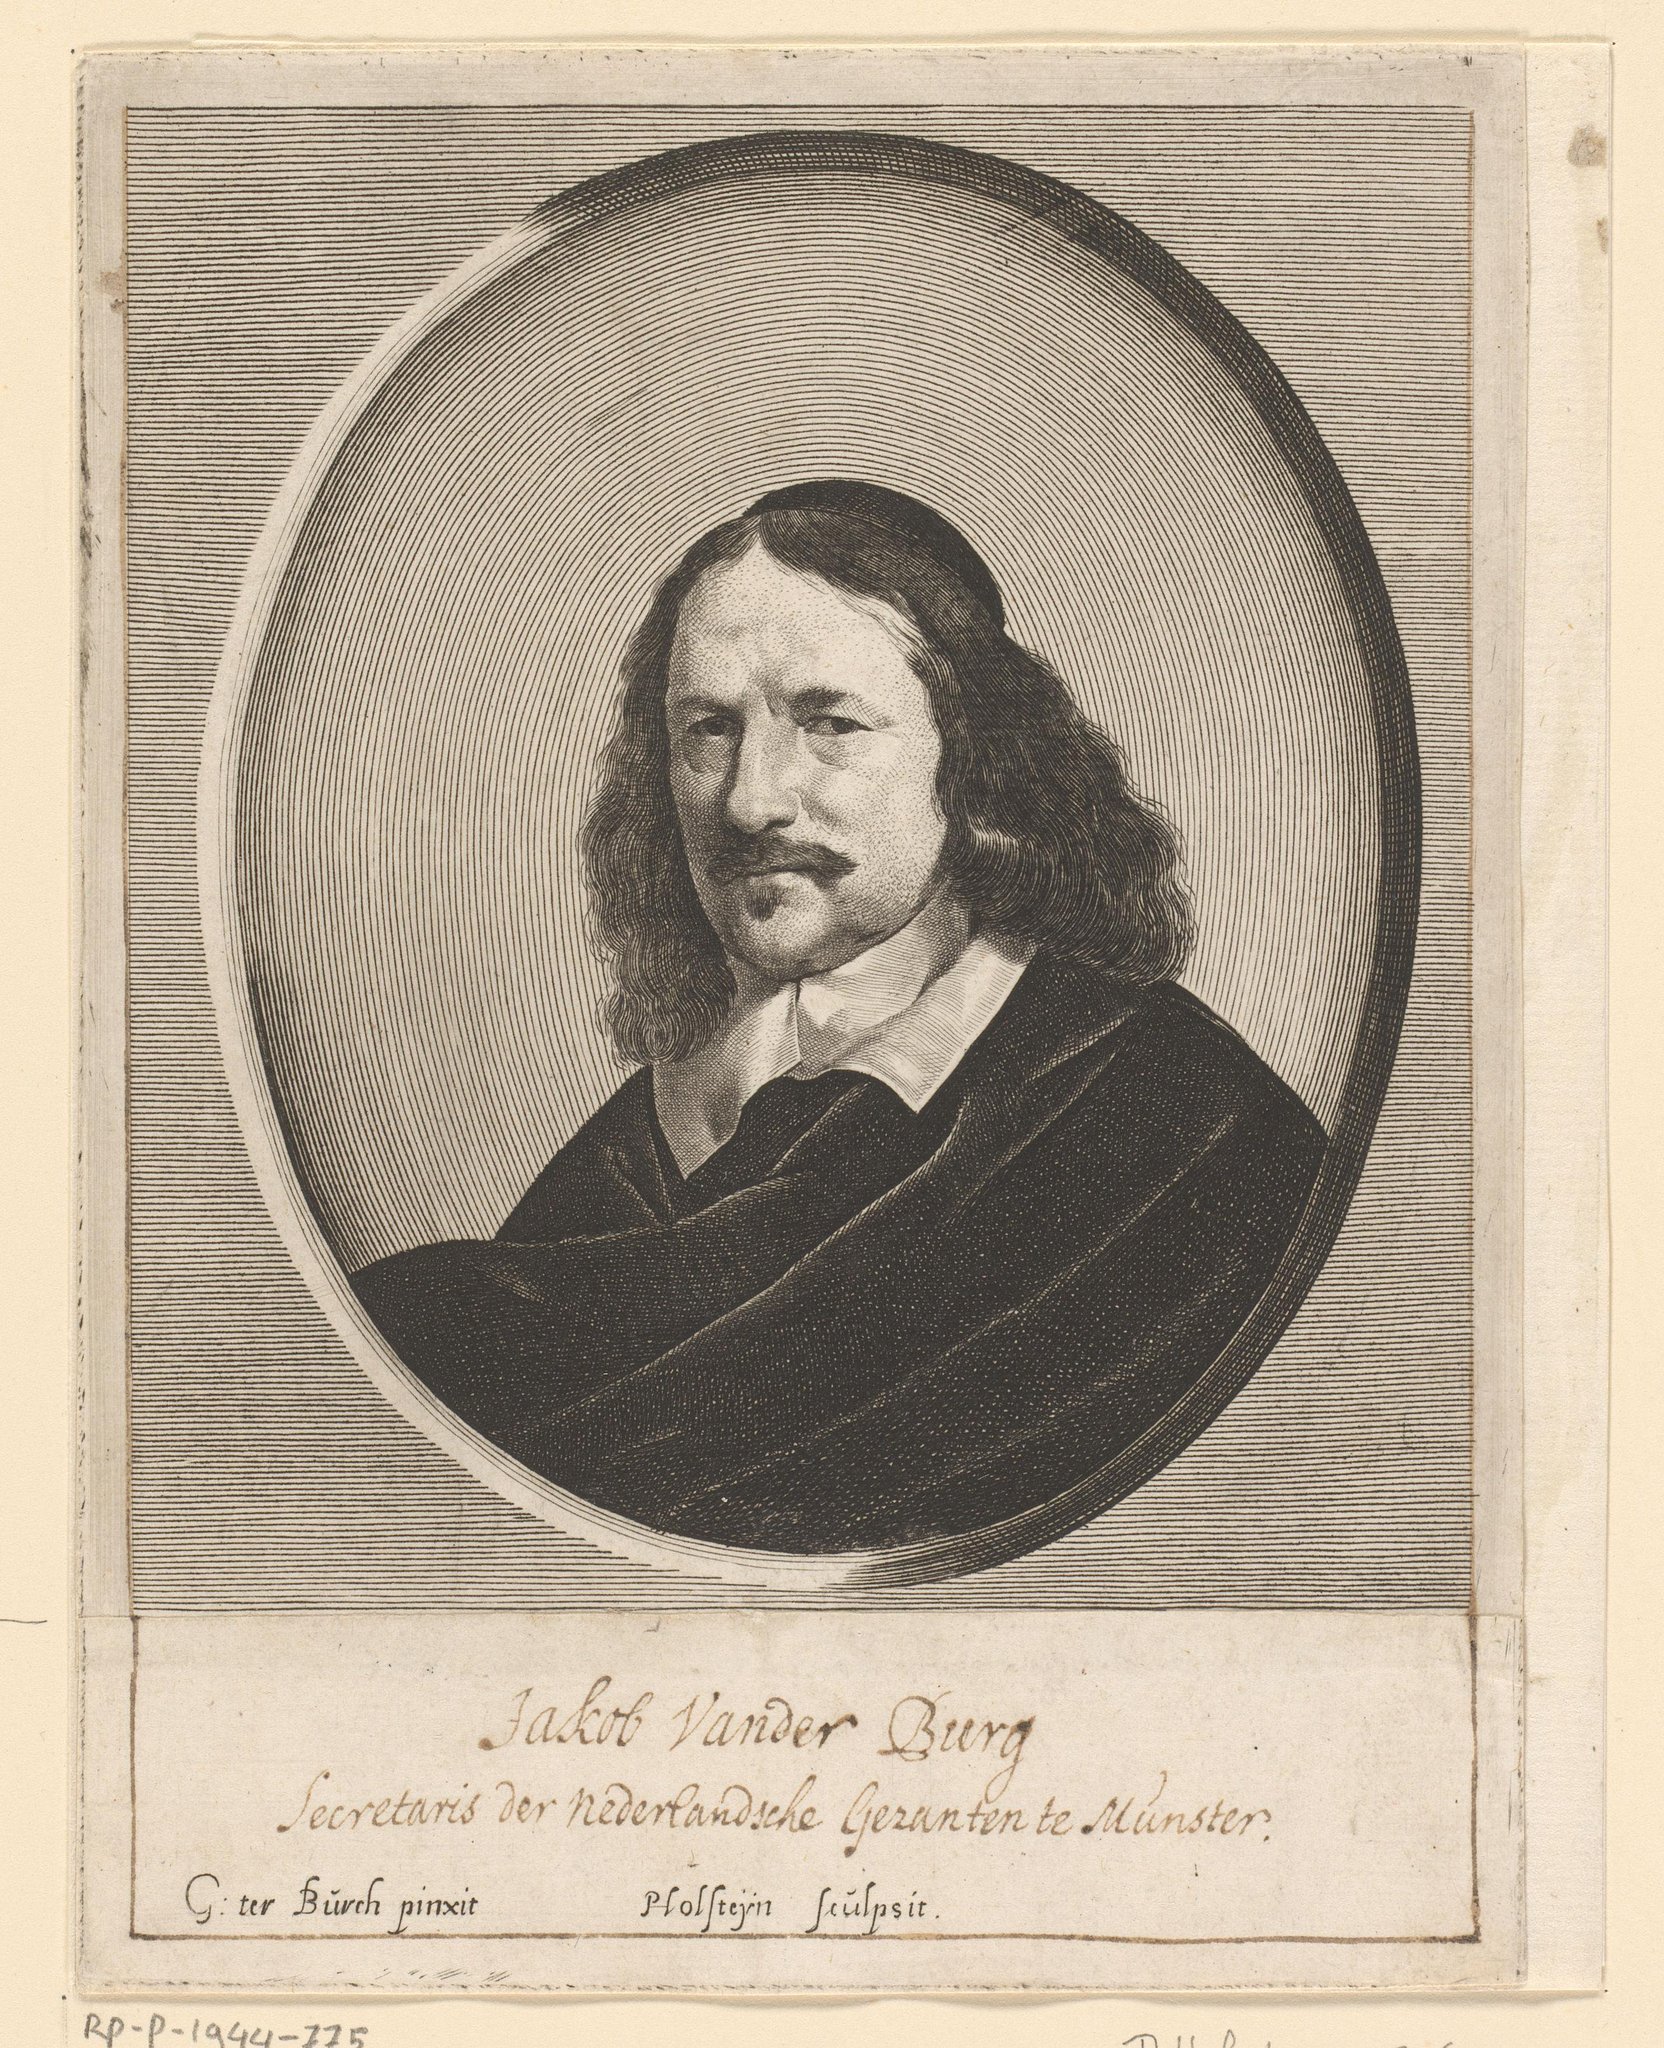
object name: print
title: Portret van Jacob van der Burgh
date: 1624-1673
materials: paper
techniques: engraving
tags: leiden, amsterdam, historical persons, secretary, scribe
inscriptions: inscription: ‘Jakob van der Burg. Secretaris der Nederlandsche Gezanten te Münster’, collector's mark: Lugt 2228